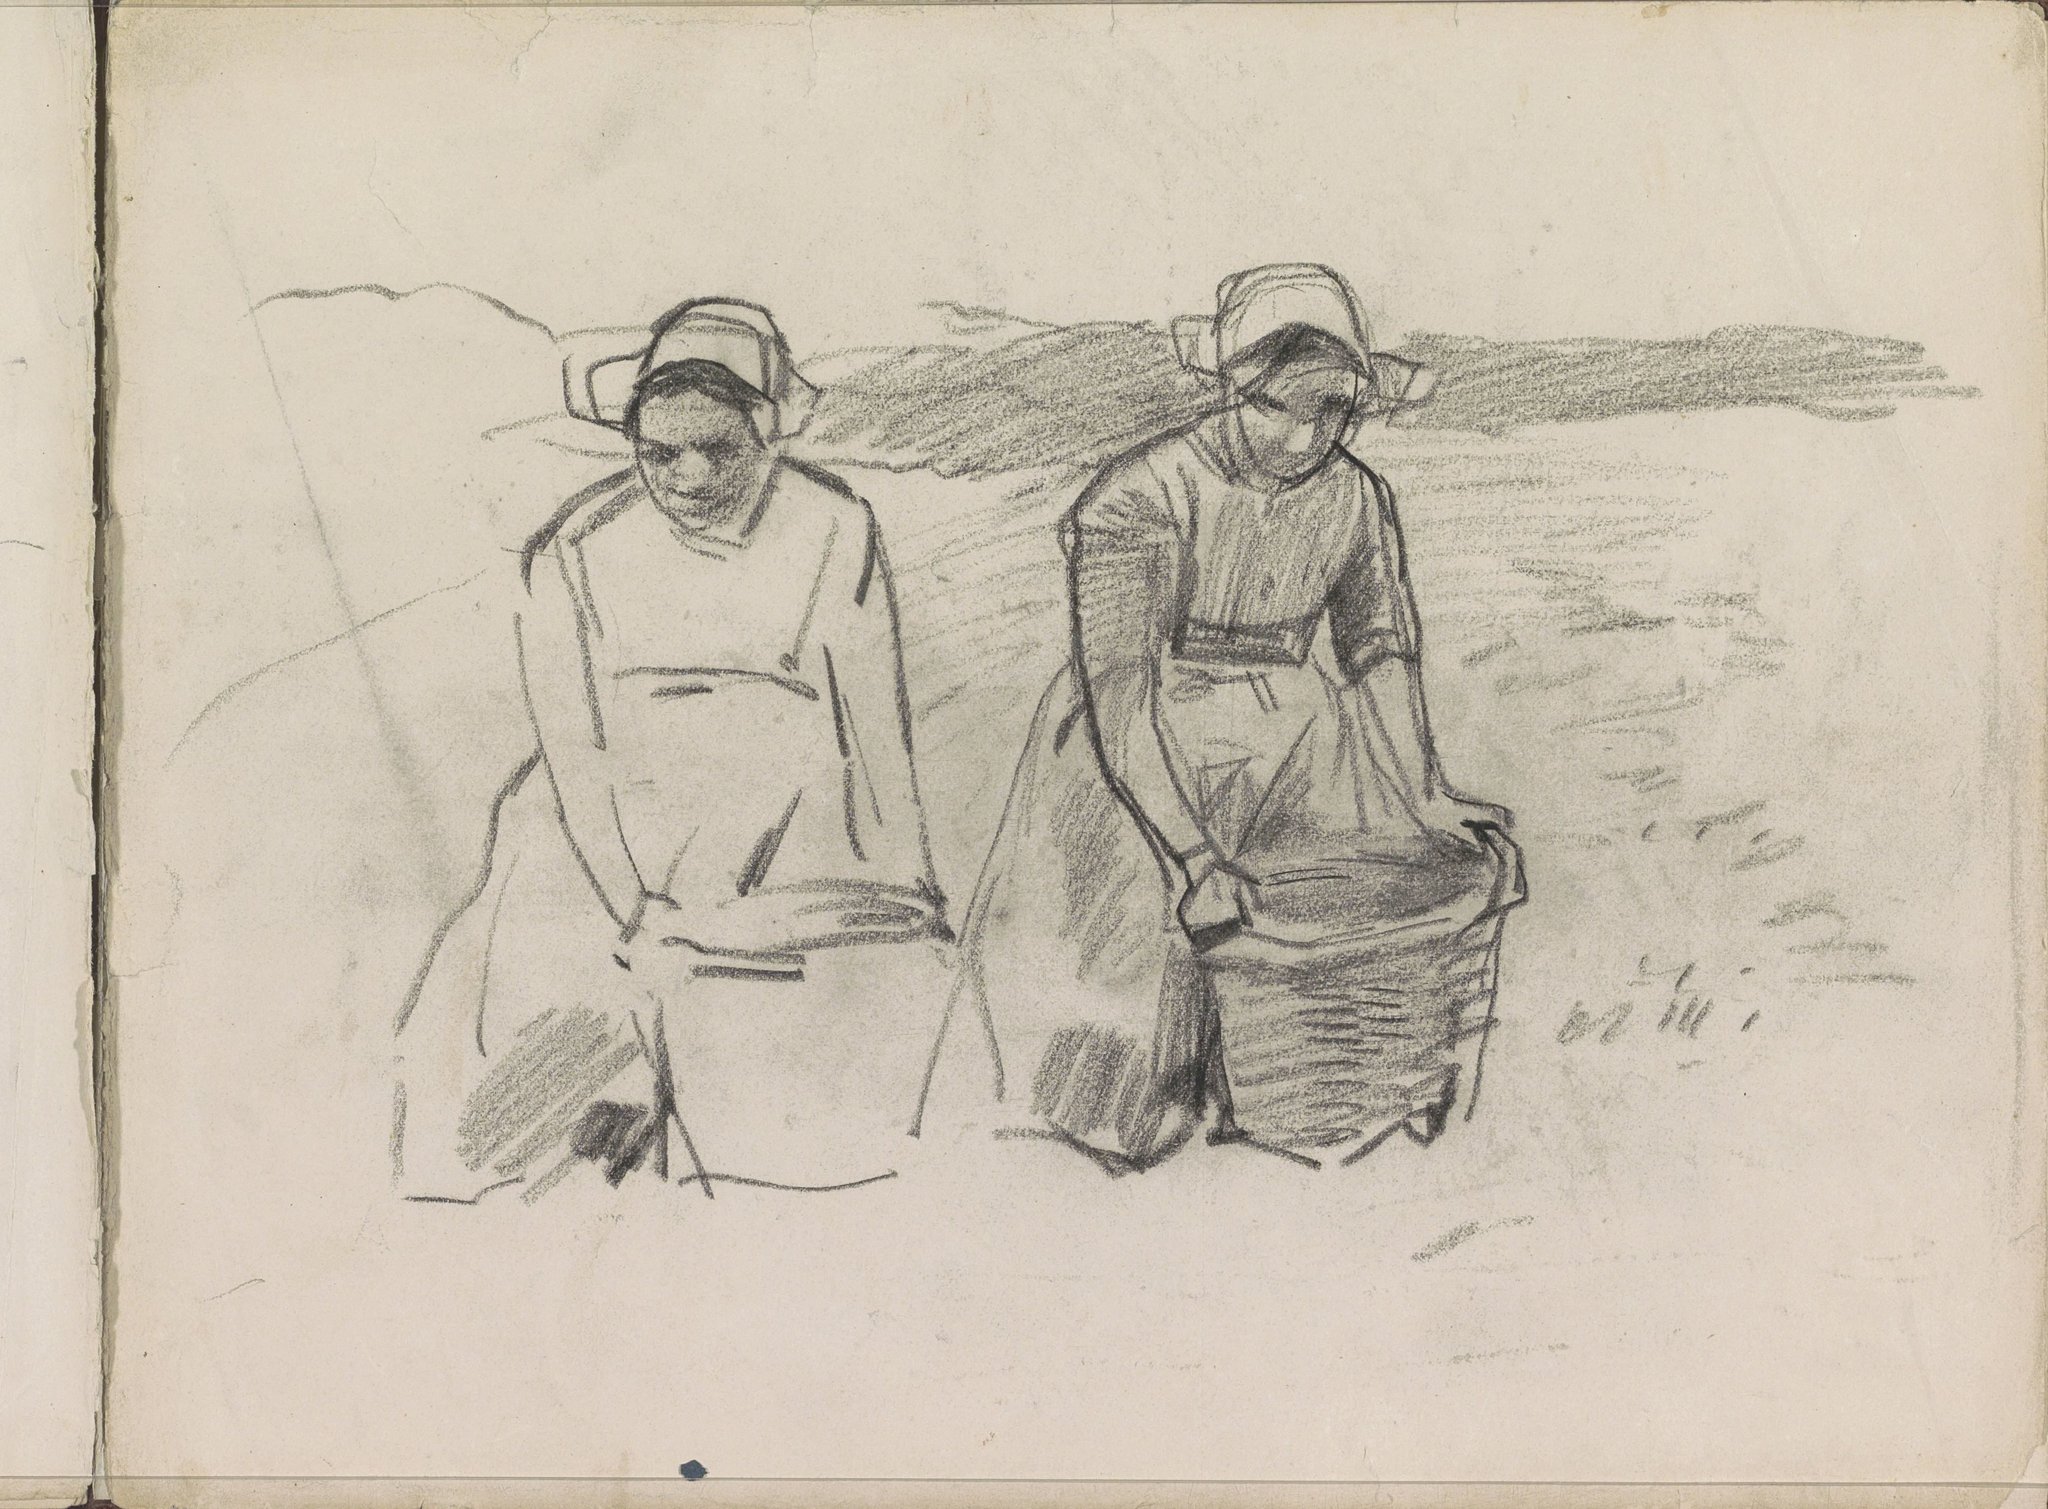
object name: sketchbook leaf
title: Twee vrouwen met manden in een landschap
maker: anton mauve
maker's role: draughtsman, painter, print maker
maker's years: 1838-1888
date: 1886-1888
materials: chalk, paper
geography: laren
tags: plants cultivated for their edible roots or tubers, e.g. potato, turnip (labourers ~ crafts, industries, agriculture), container made of plant material other than wood: basket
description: De vrouwen dragen een kap op het hoofd, vermoedelijk gaat het om streekkostuum. Zij zitten geknield bij hun mand, vermoedelijk zijn zij aardappelrooisters. Blad 25 recto uit een schetsboek met 27 bladen.